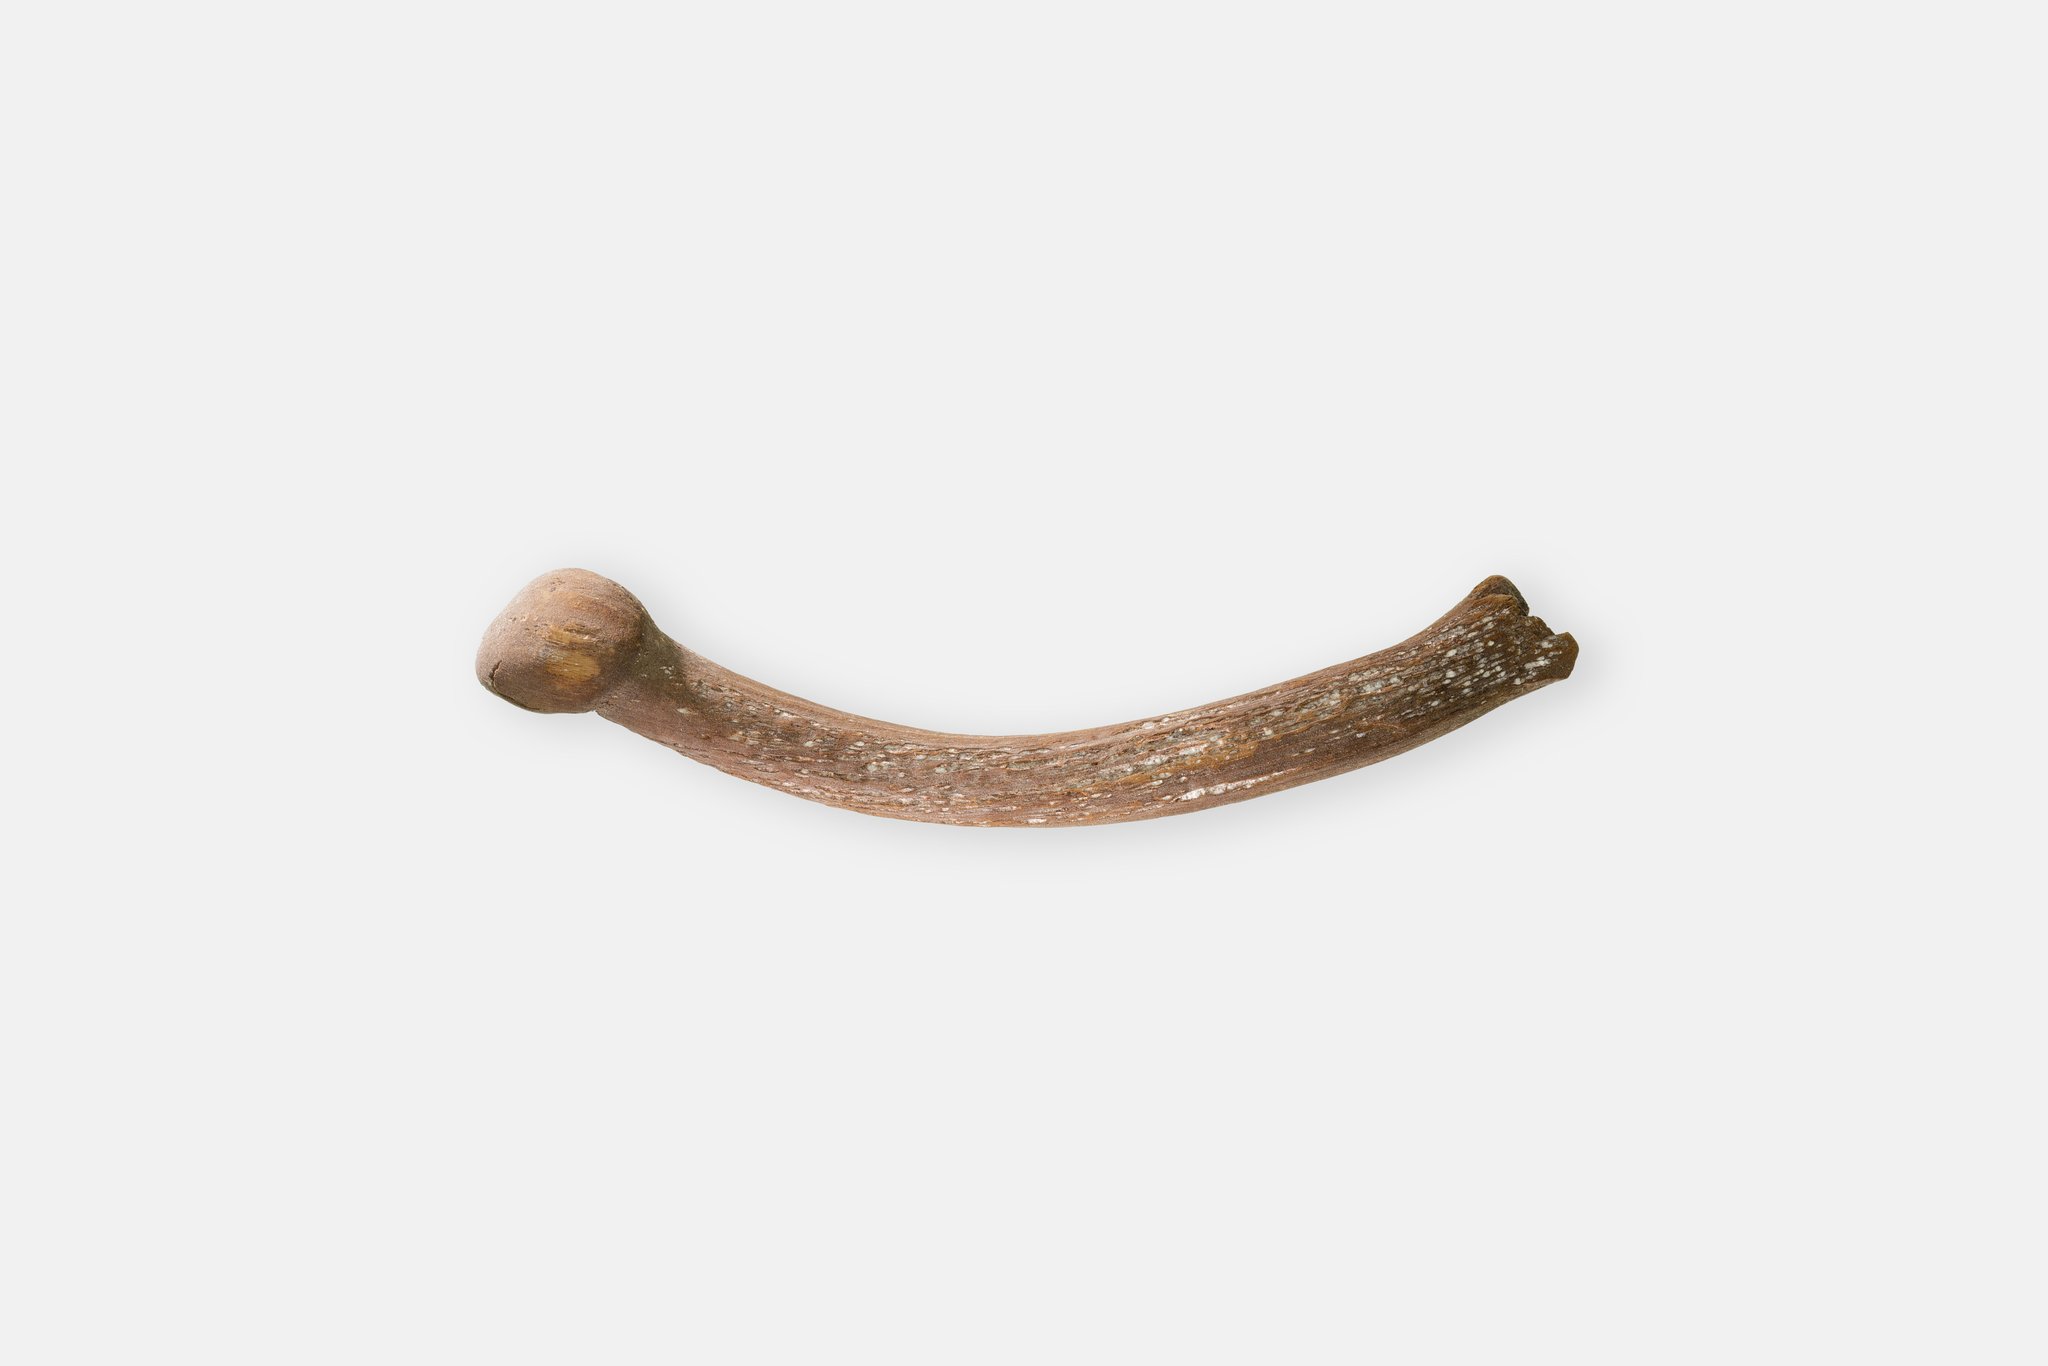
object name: razor handle, amenemhat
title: Razor Handle for 35.3.28a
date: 1504-1447 BCE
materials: wood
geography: egypt